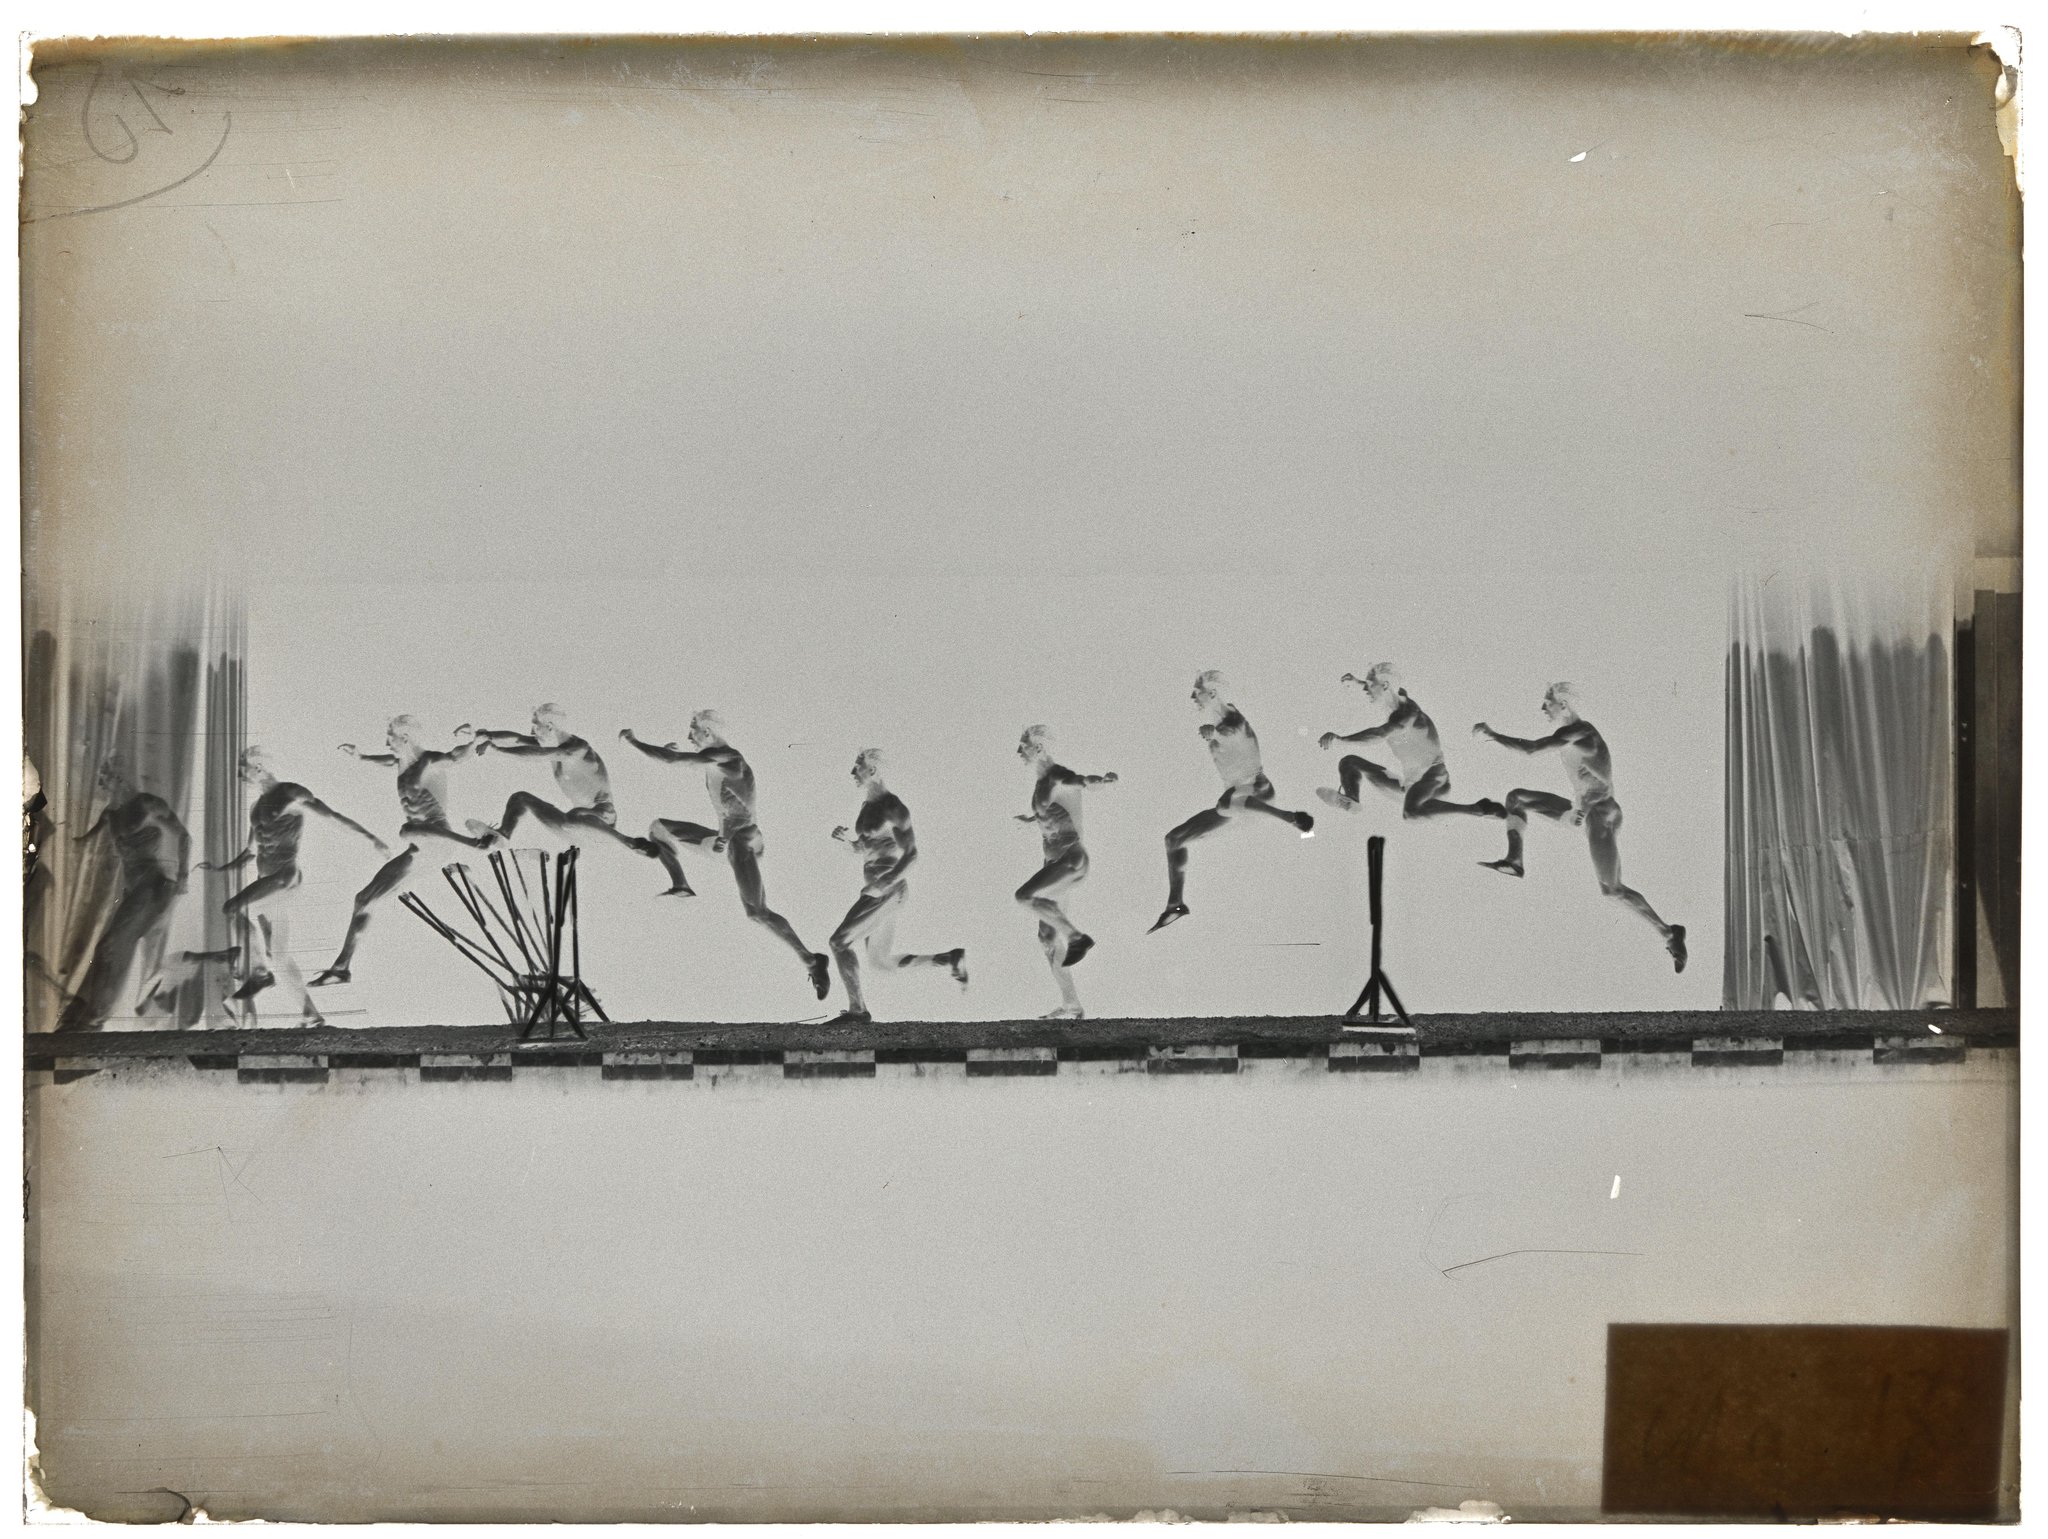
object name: glasnegatief, glasplaatnegatief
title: Hurdler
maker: étienne-jules marey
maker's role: fotograaf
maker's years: 1830-1904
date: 1882-1890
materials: glass, paper, pencil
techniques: gelatin glass negative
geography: france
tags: adult man, automobile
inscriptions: inscription: ‘Ma. 17’, number: ‘18’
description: Bij de negatieven zijn ook de duplicaatnegatieven en moderne afdrukken die voor de boekpublicatie vervaardigd zijn.